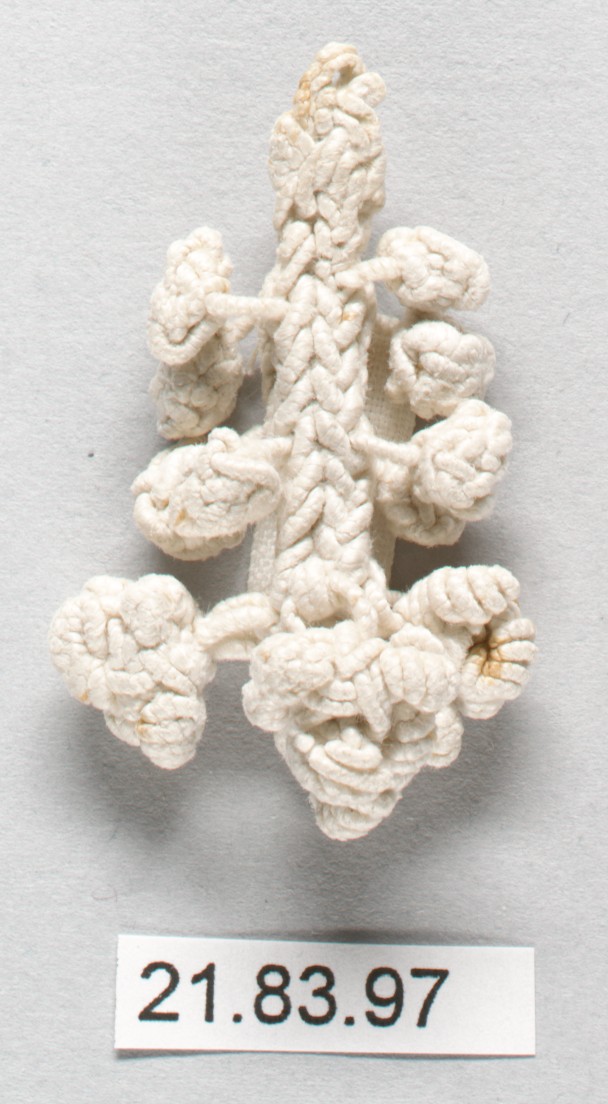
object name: tassel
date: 1601-1700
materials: linen